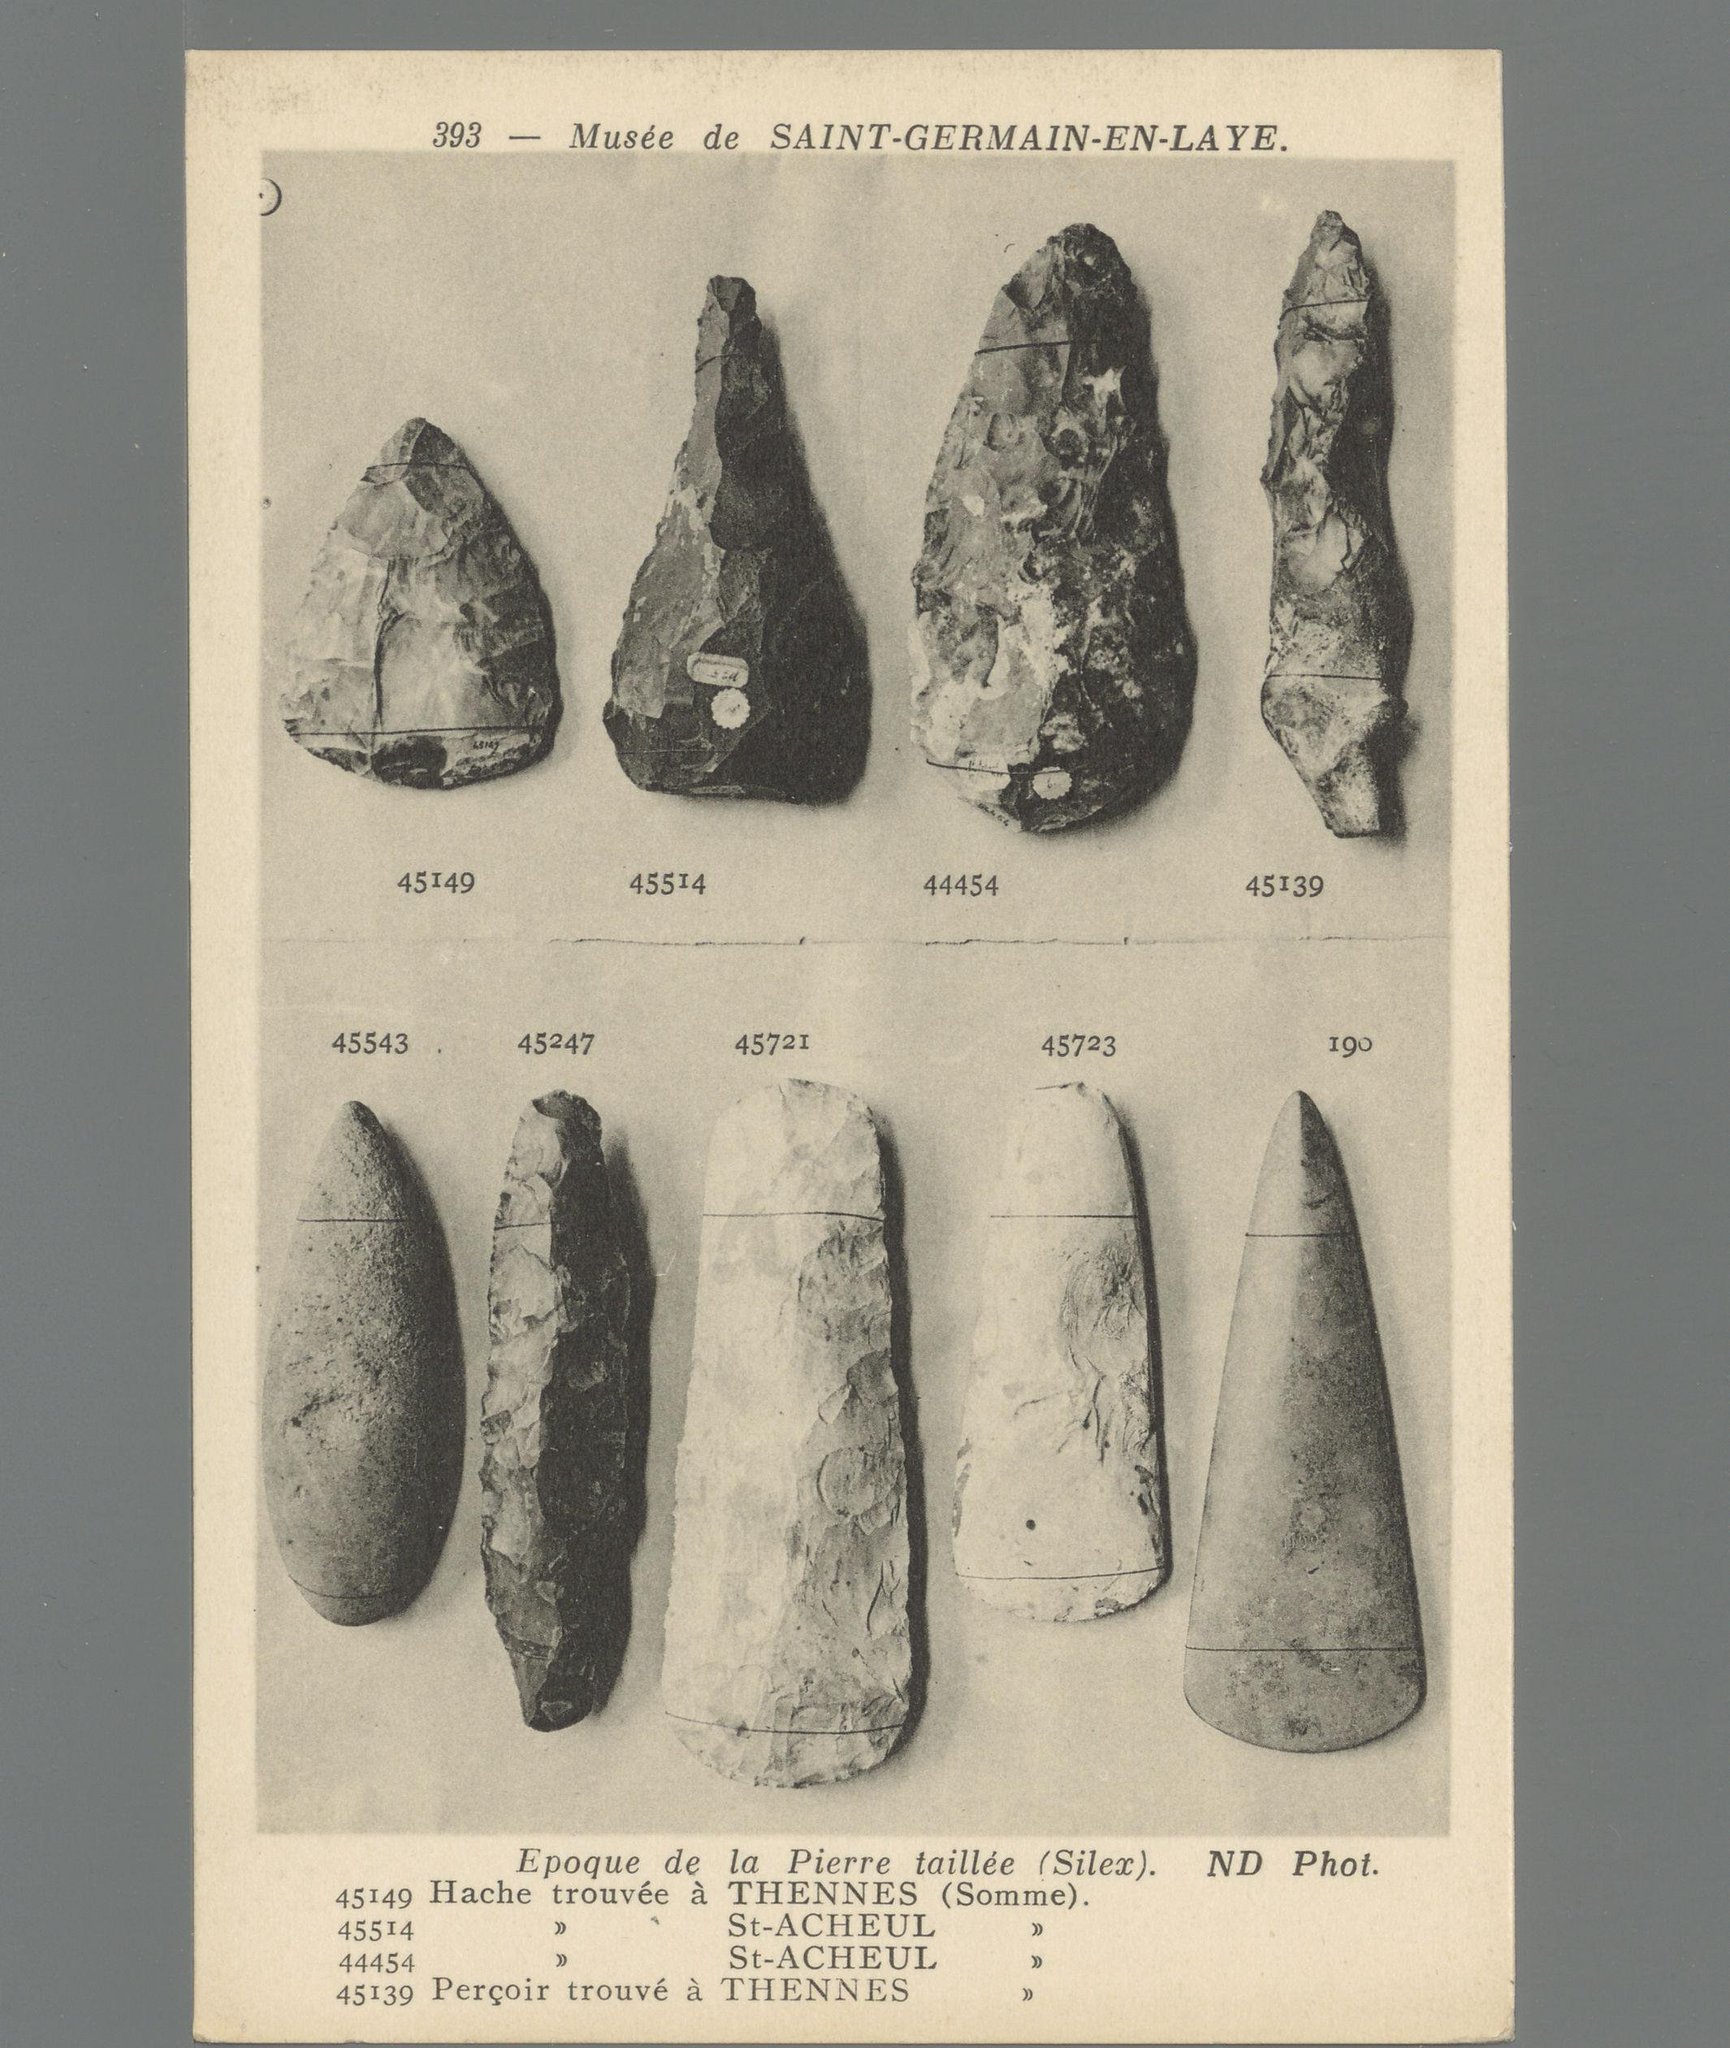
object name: ansichtkaart, prentbriefkaart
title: Epoque de la Pierre taillée (Silex)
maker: Anonymous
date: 1903-1918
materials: cardboard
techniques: photograph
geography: paris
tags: handicrafts ~ stone, tools, aids, implements ~ crafts and industries: axe, permanent exhibition, museum